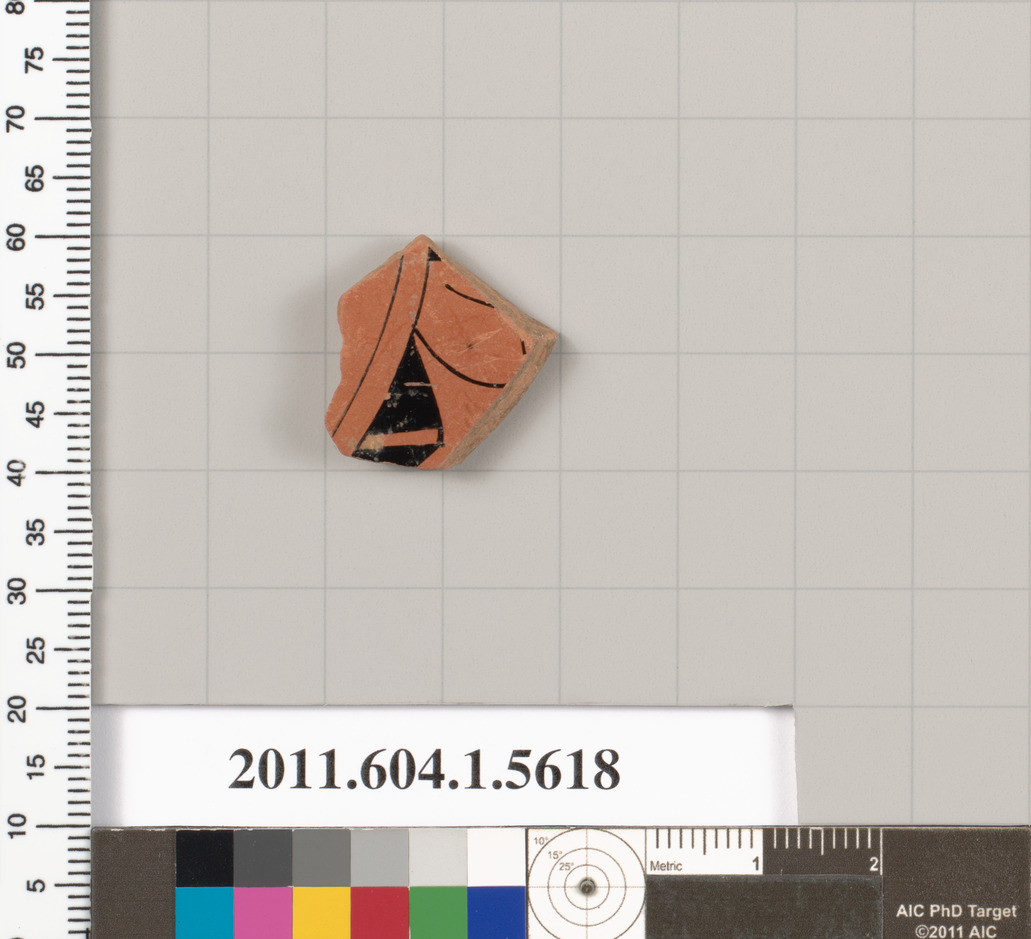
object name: kylix fragment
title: Terracotta fragment of a kylix (drinking cup)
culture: greek, attic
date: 510-490 BCE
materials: terracotta